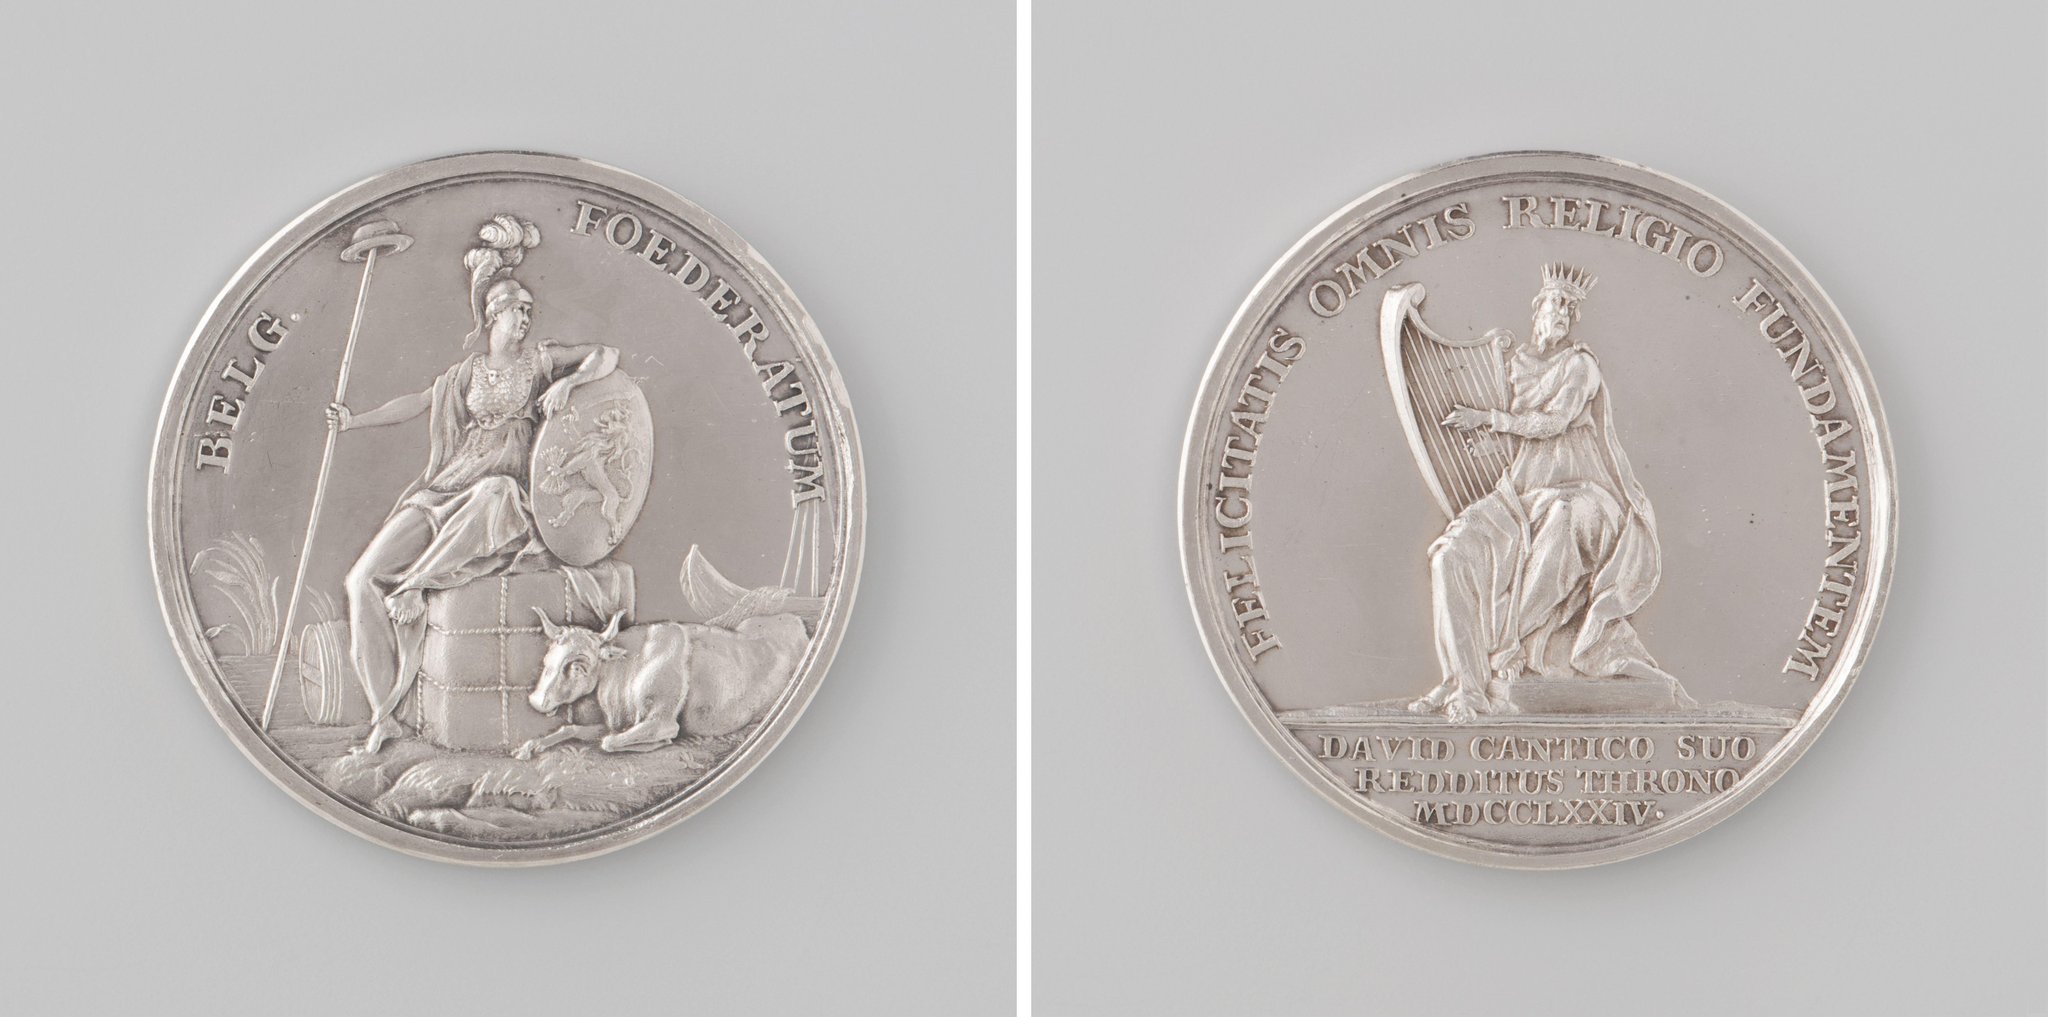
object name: history medal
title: Invoering van de nieuwe psalmberijming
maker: Anonymous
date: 1774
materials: silver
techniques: striking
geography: netherlands